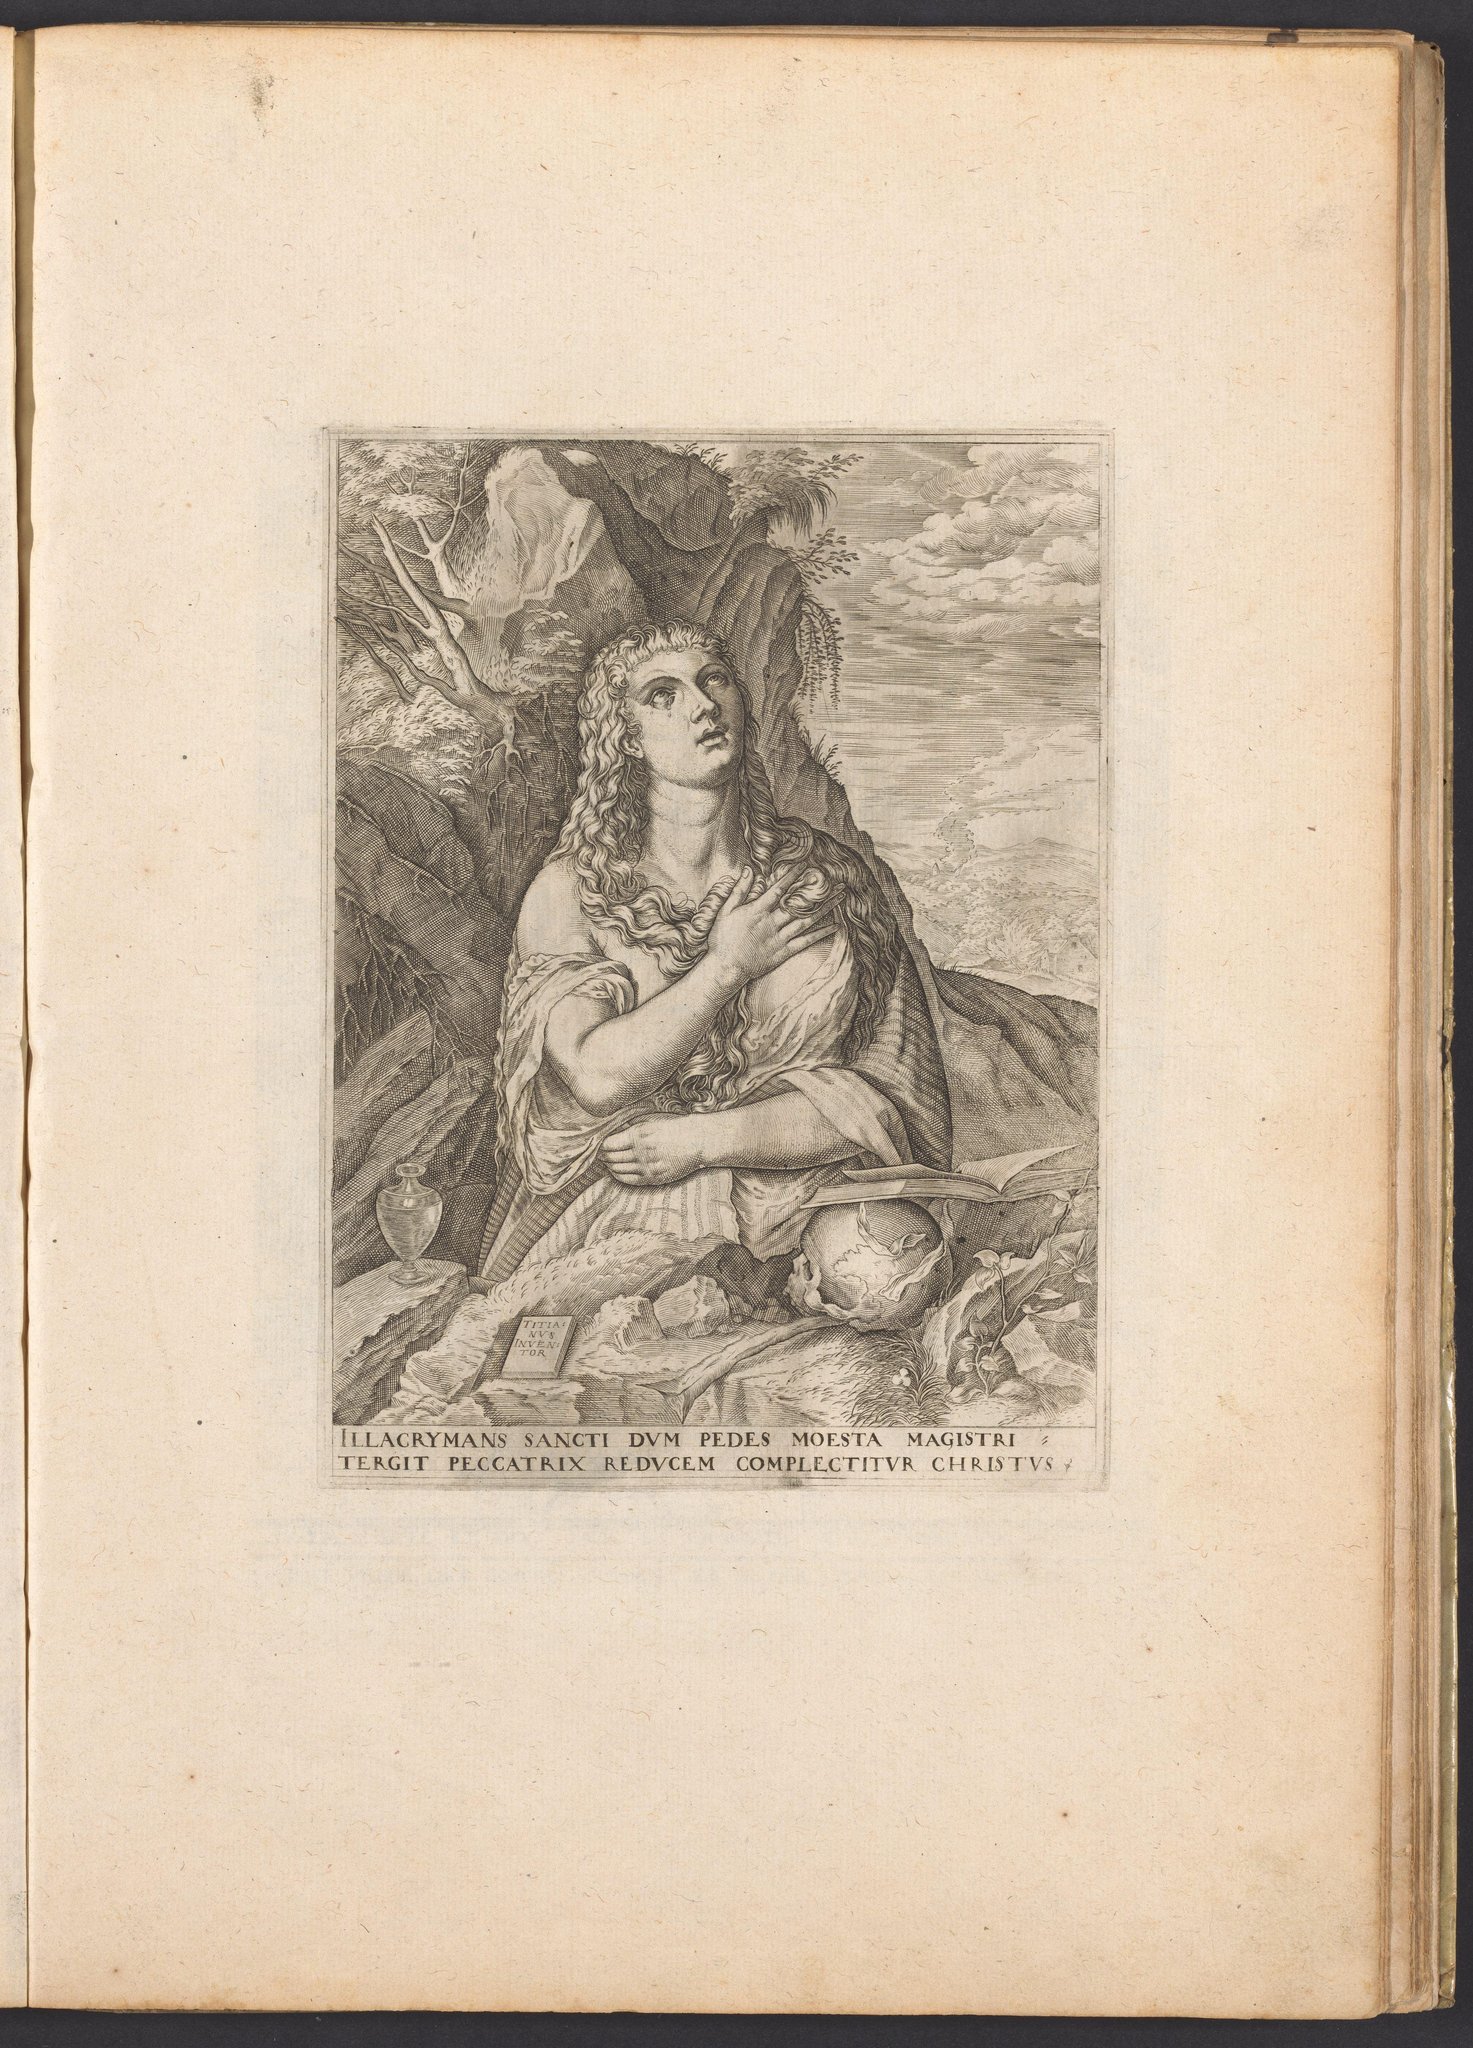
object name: album leaf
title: Boetvaardige Maria Magdalena in de wildernis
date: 1572-1582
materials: paper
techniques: engraving, etching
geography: italy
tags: the penitent st. mary magdalene (often before a cave, possibly at la sainte-baume hill): her long hair covers her (naked) body, she reads, meditates or raises her tear-filled eyes towards heaven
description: Deze prent maakt deel uit van een album.